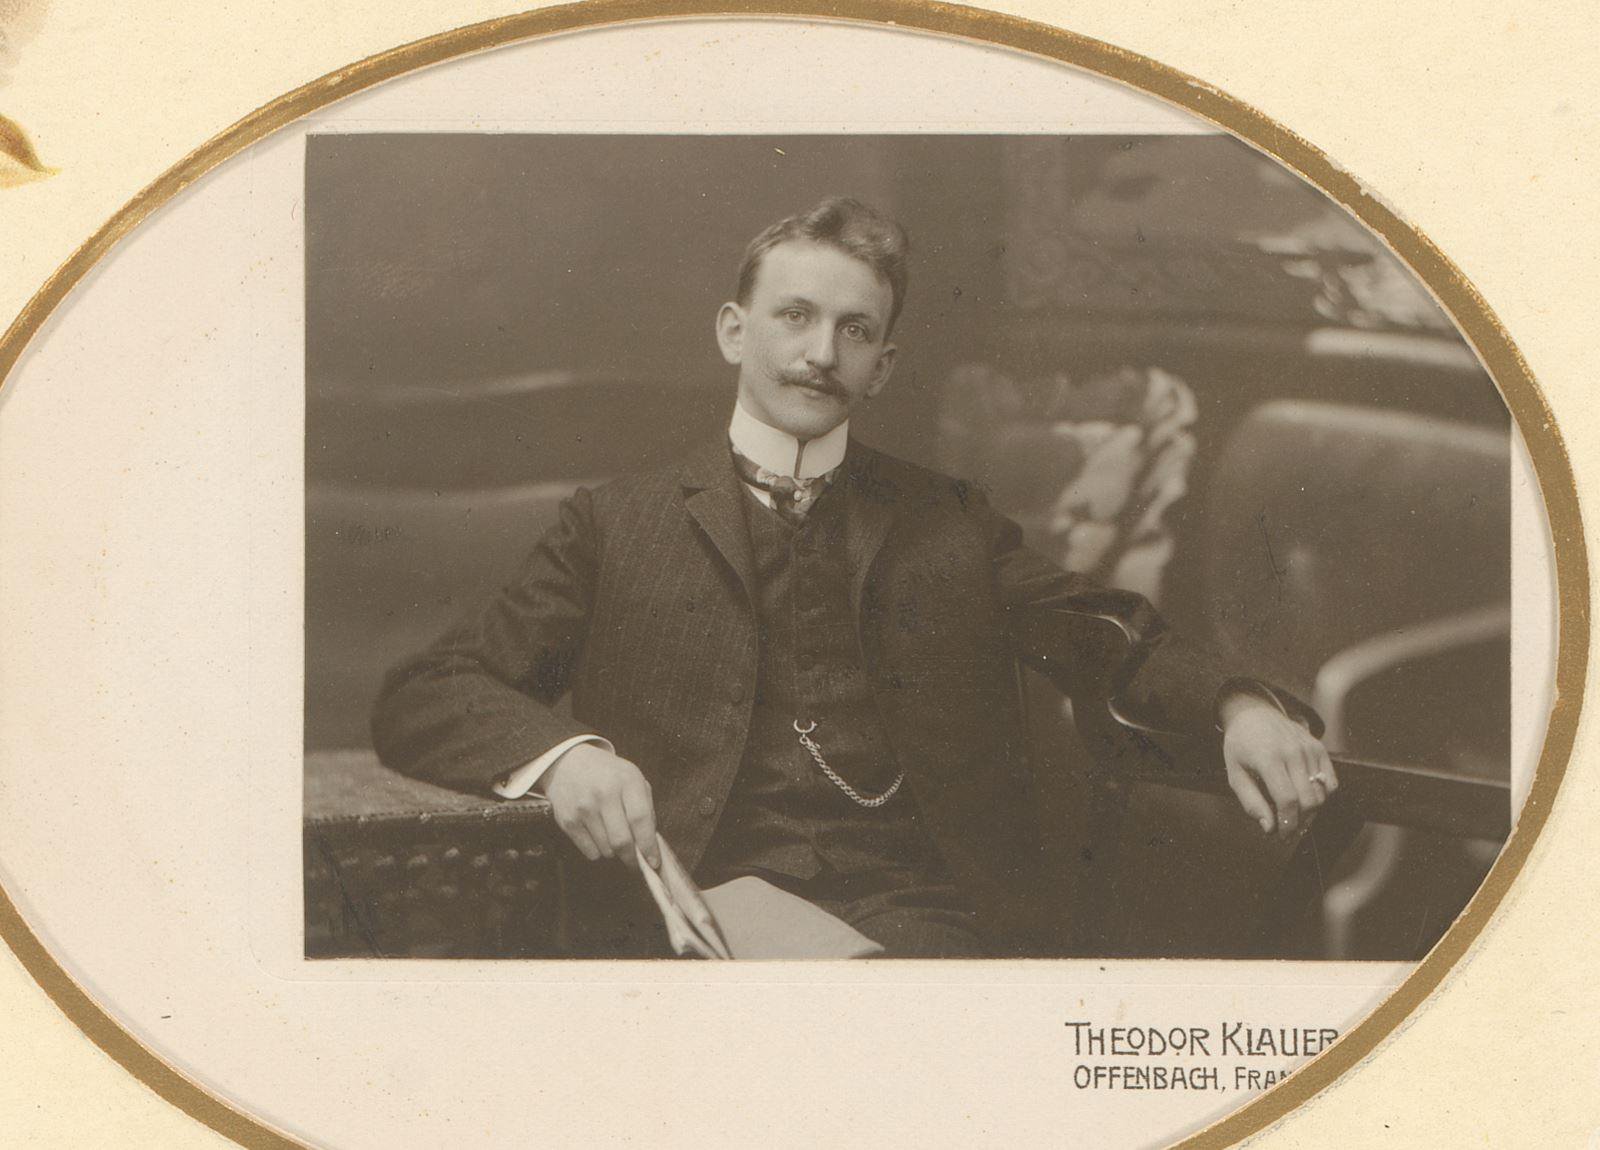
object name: cabinet photograph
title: Portret van een zittende man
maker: theodor klauer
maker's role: fotograaf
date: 1895-1920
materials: cardboard, photographic support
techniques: matte daylight collodion silver print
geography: offenbach am main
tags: sitting figure, historical persons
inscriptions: inscription: ‘Theodor Klauer/ OFFENBACH, Frankfurter Str. 34.’